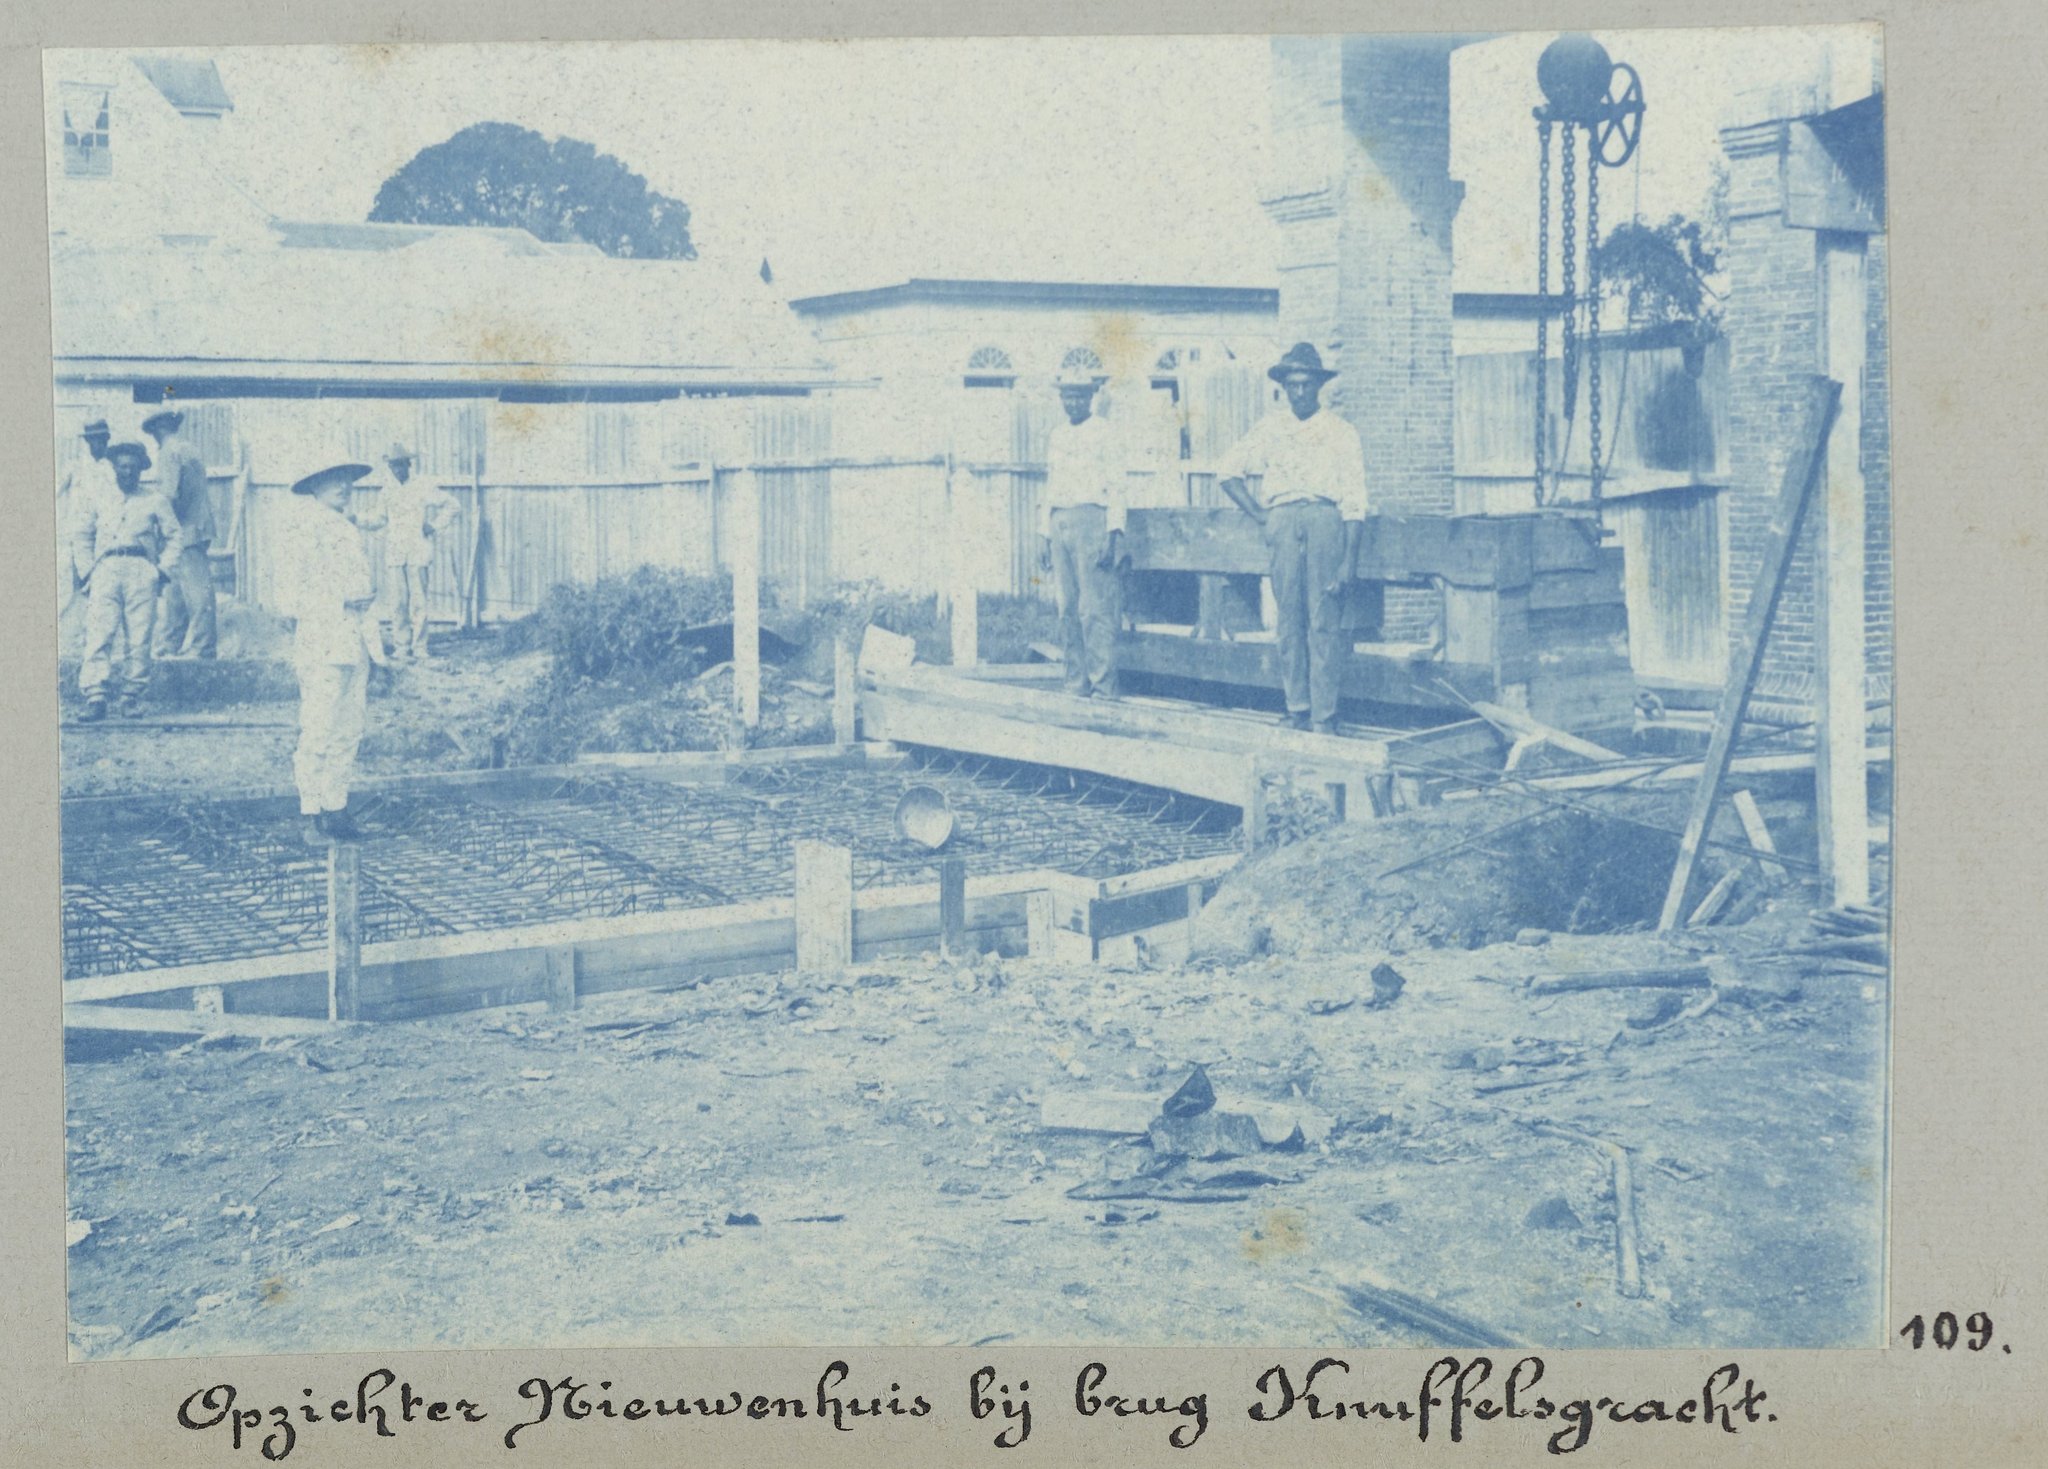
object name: photograph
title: Opzichter Nieuwenhuis bij brug Knuffelsgracht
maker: hendrik doijer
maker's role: engineer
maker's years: 1863-1925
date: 1903-1910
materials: photographic support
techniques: cyanotype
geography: suriname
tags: suriname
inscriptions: inscription: ‘109. / Opzichter Nieuwenhuis bij brug Knuffelsgracht.’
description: De Nederlandse opzichter Nieuwenhuis staande bij werkzaamheden aan de bouw van de brug over de Knuffelsgracht te Paramaribo. Onderdeel van het fotoalbum Souvenir de Voyage (deel 1), over het leven van de familie Doijer in en rond de plantage Ma Retraite in Suriname in de jaren 1903-1910.